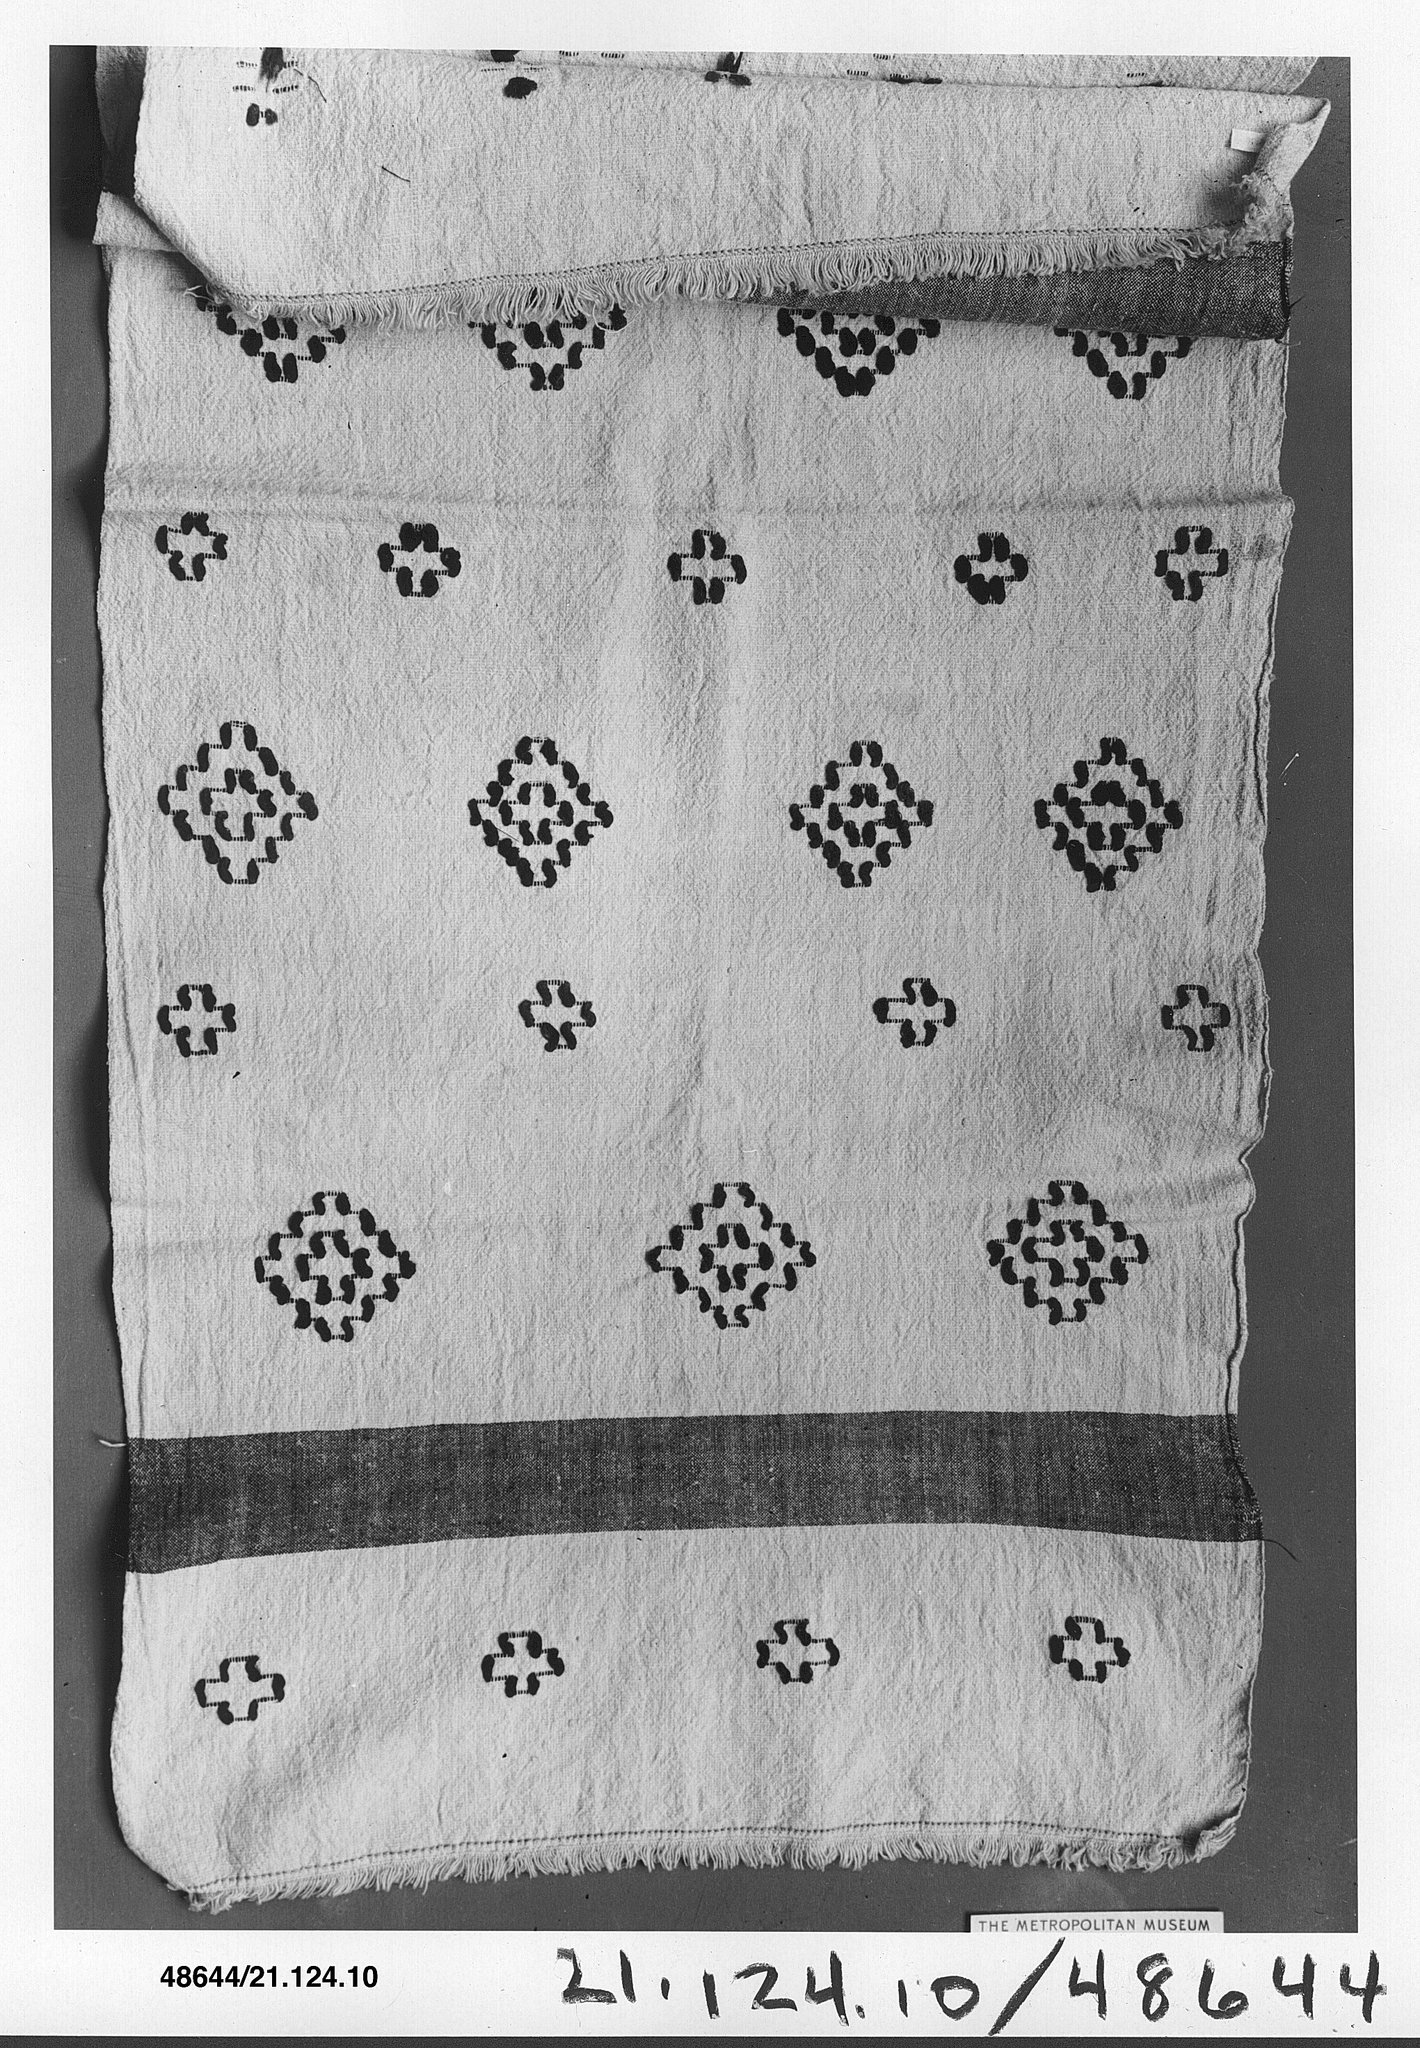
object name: towel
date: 1801-1900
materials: linen